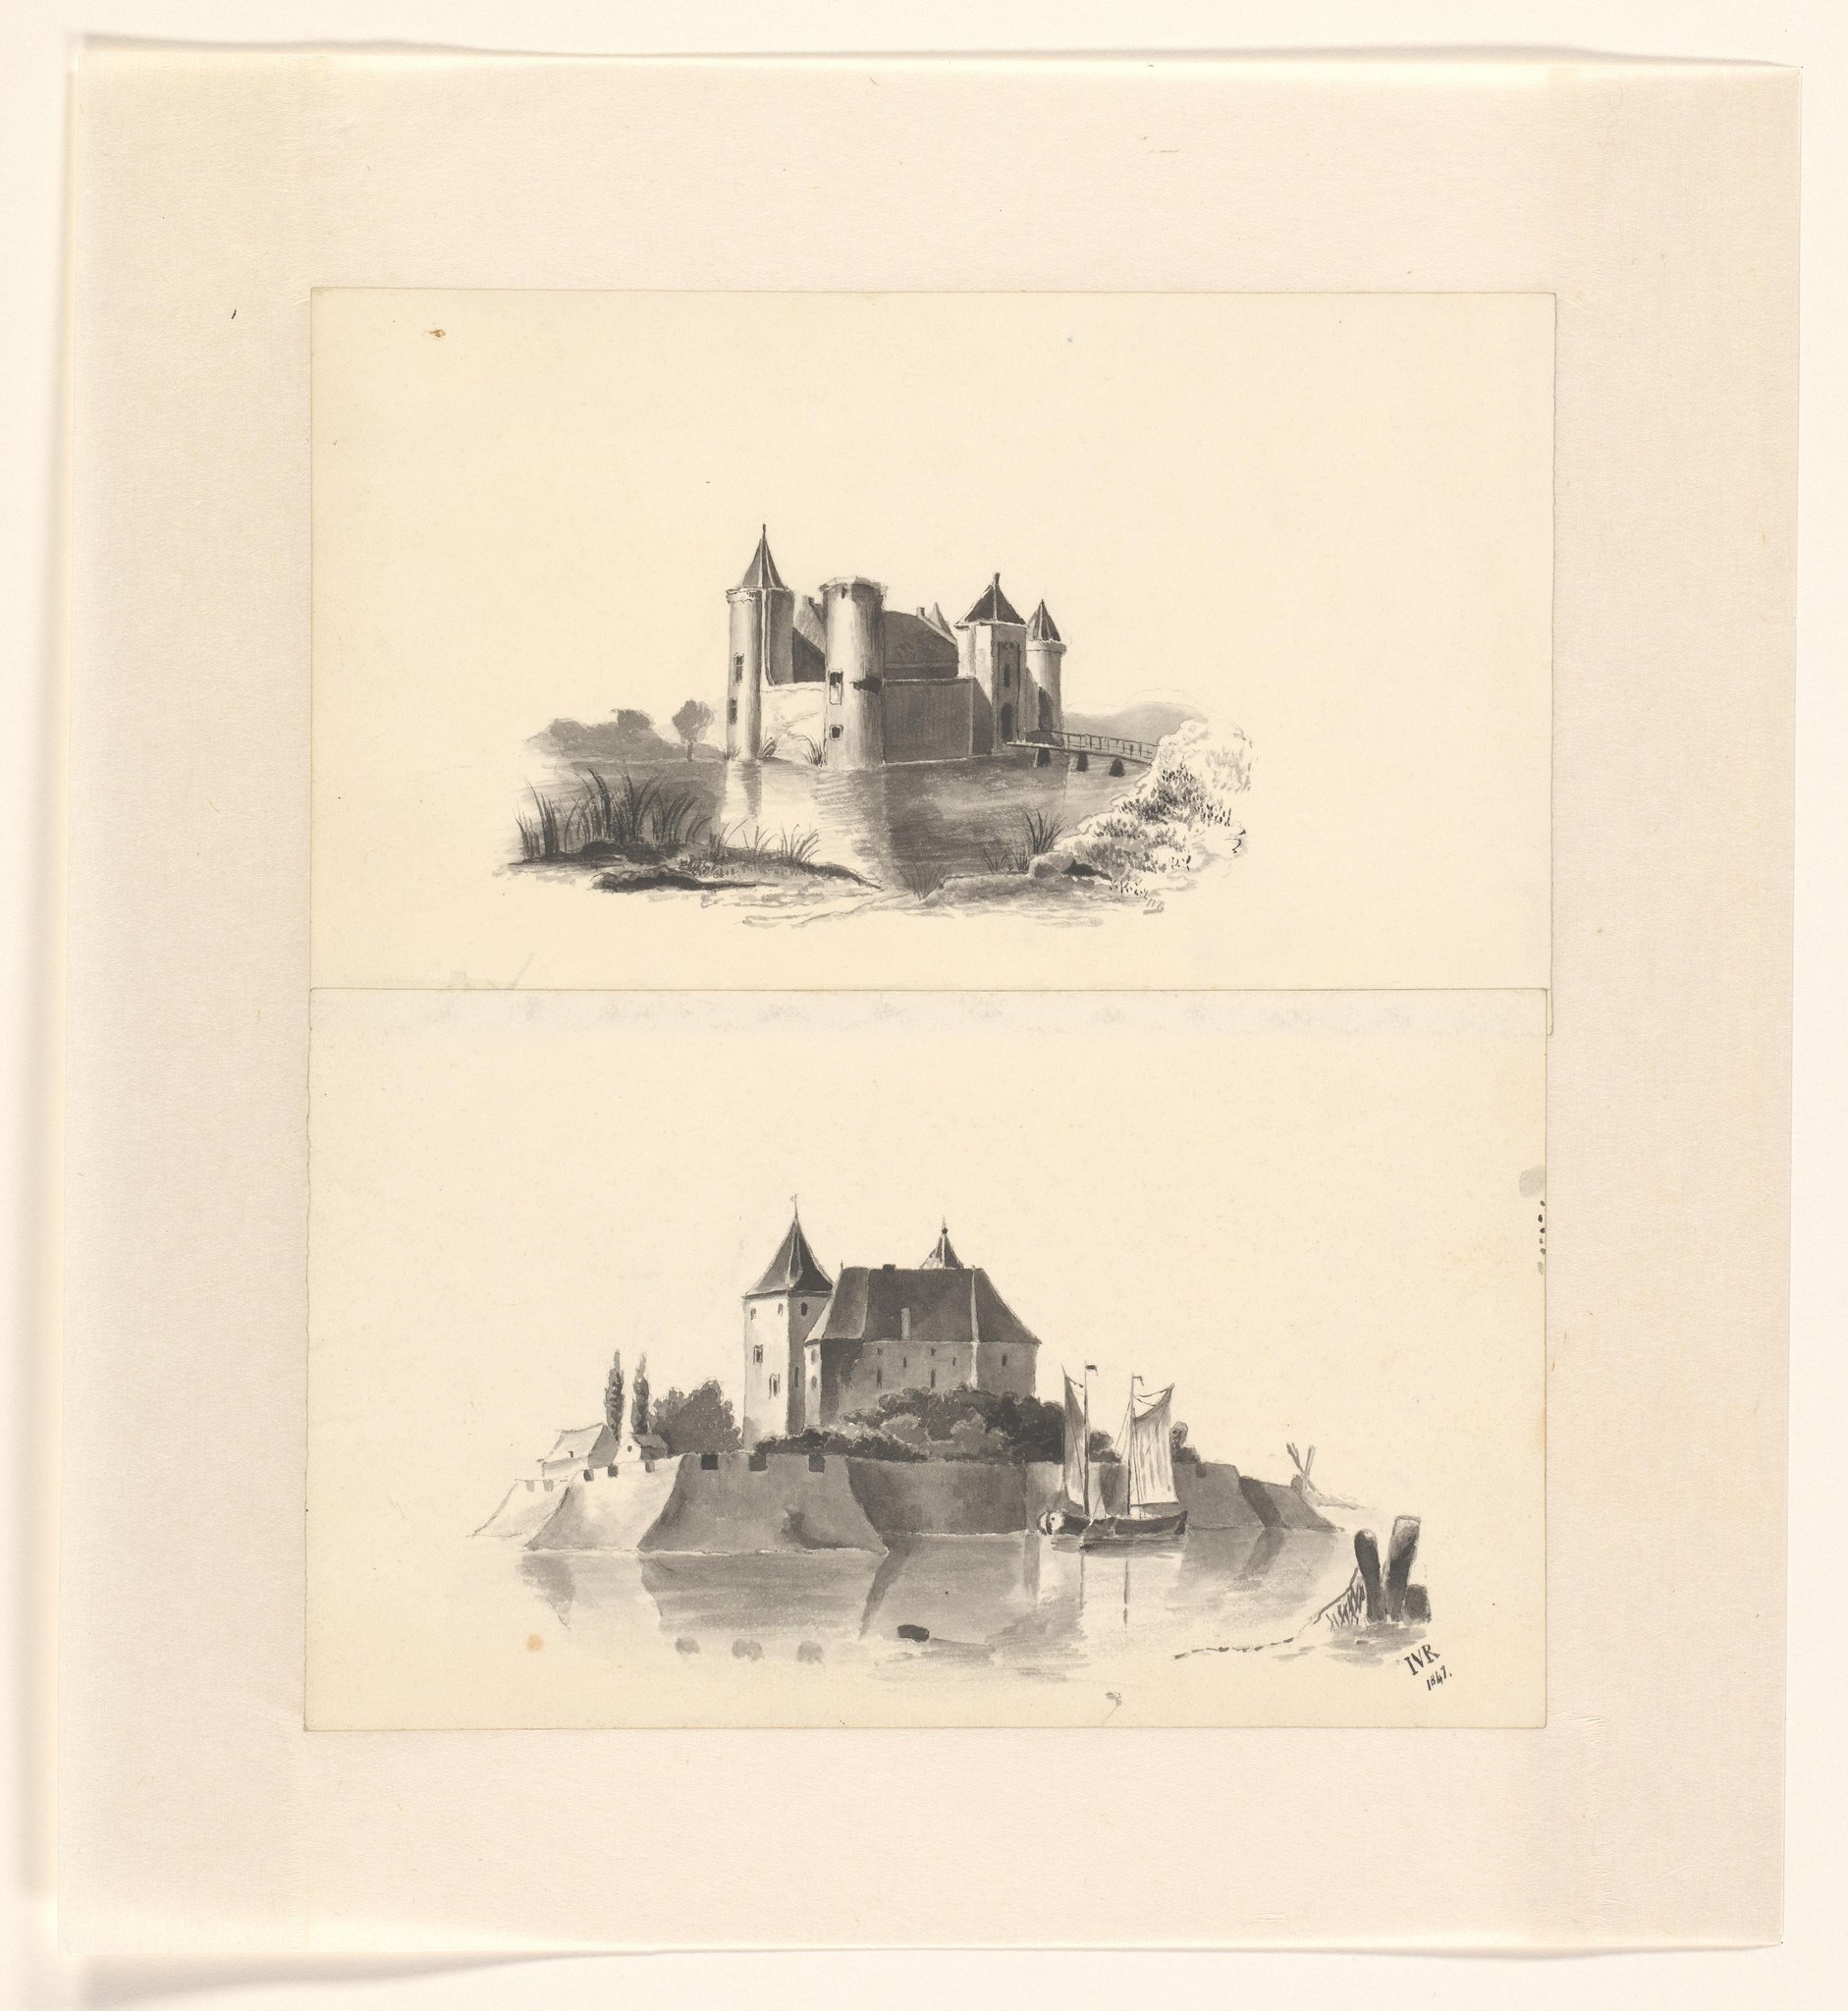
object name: drawing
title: Twee voorstellingen van een kasteel omgeven door water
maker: johannes van reijn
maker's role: draughtsman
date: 1847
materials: paper, pencil, watercolor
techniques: brush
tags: castle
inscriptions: date